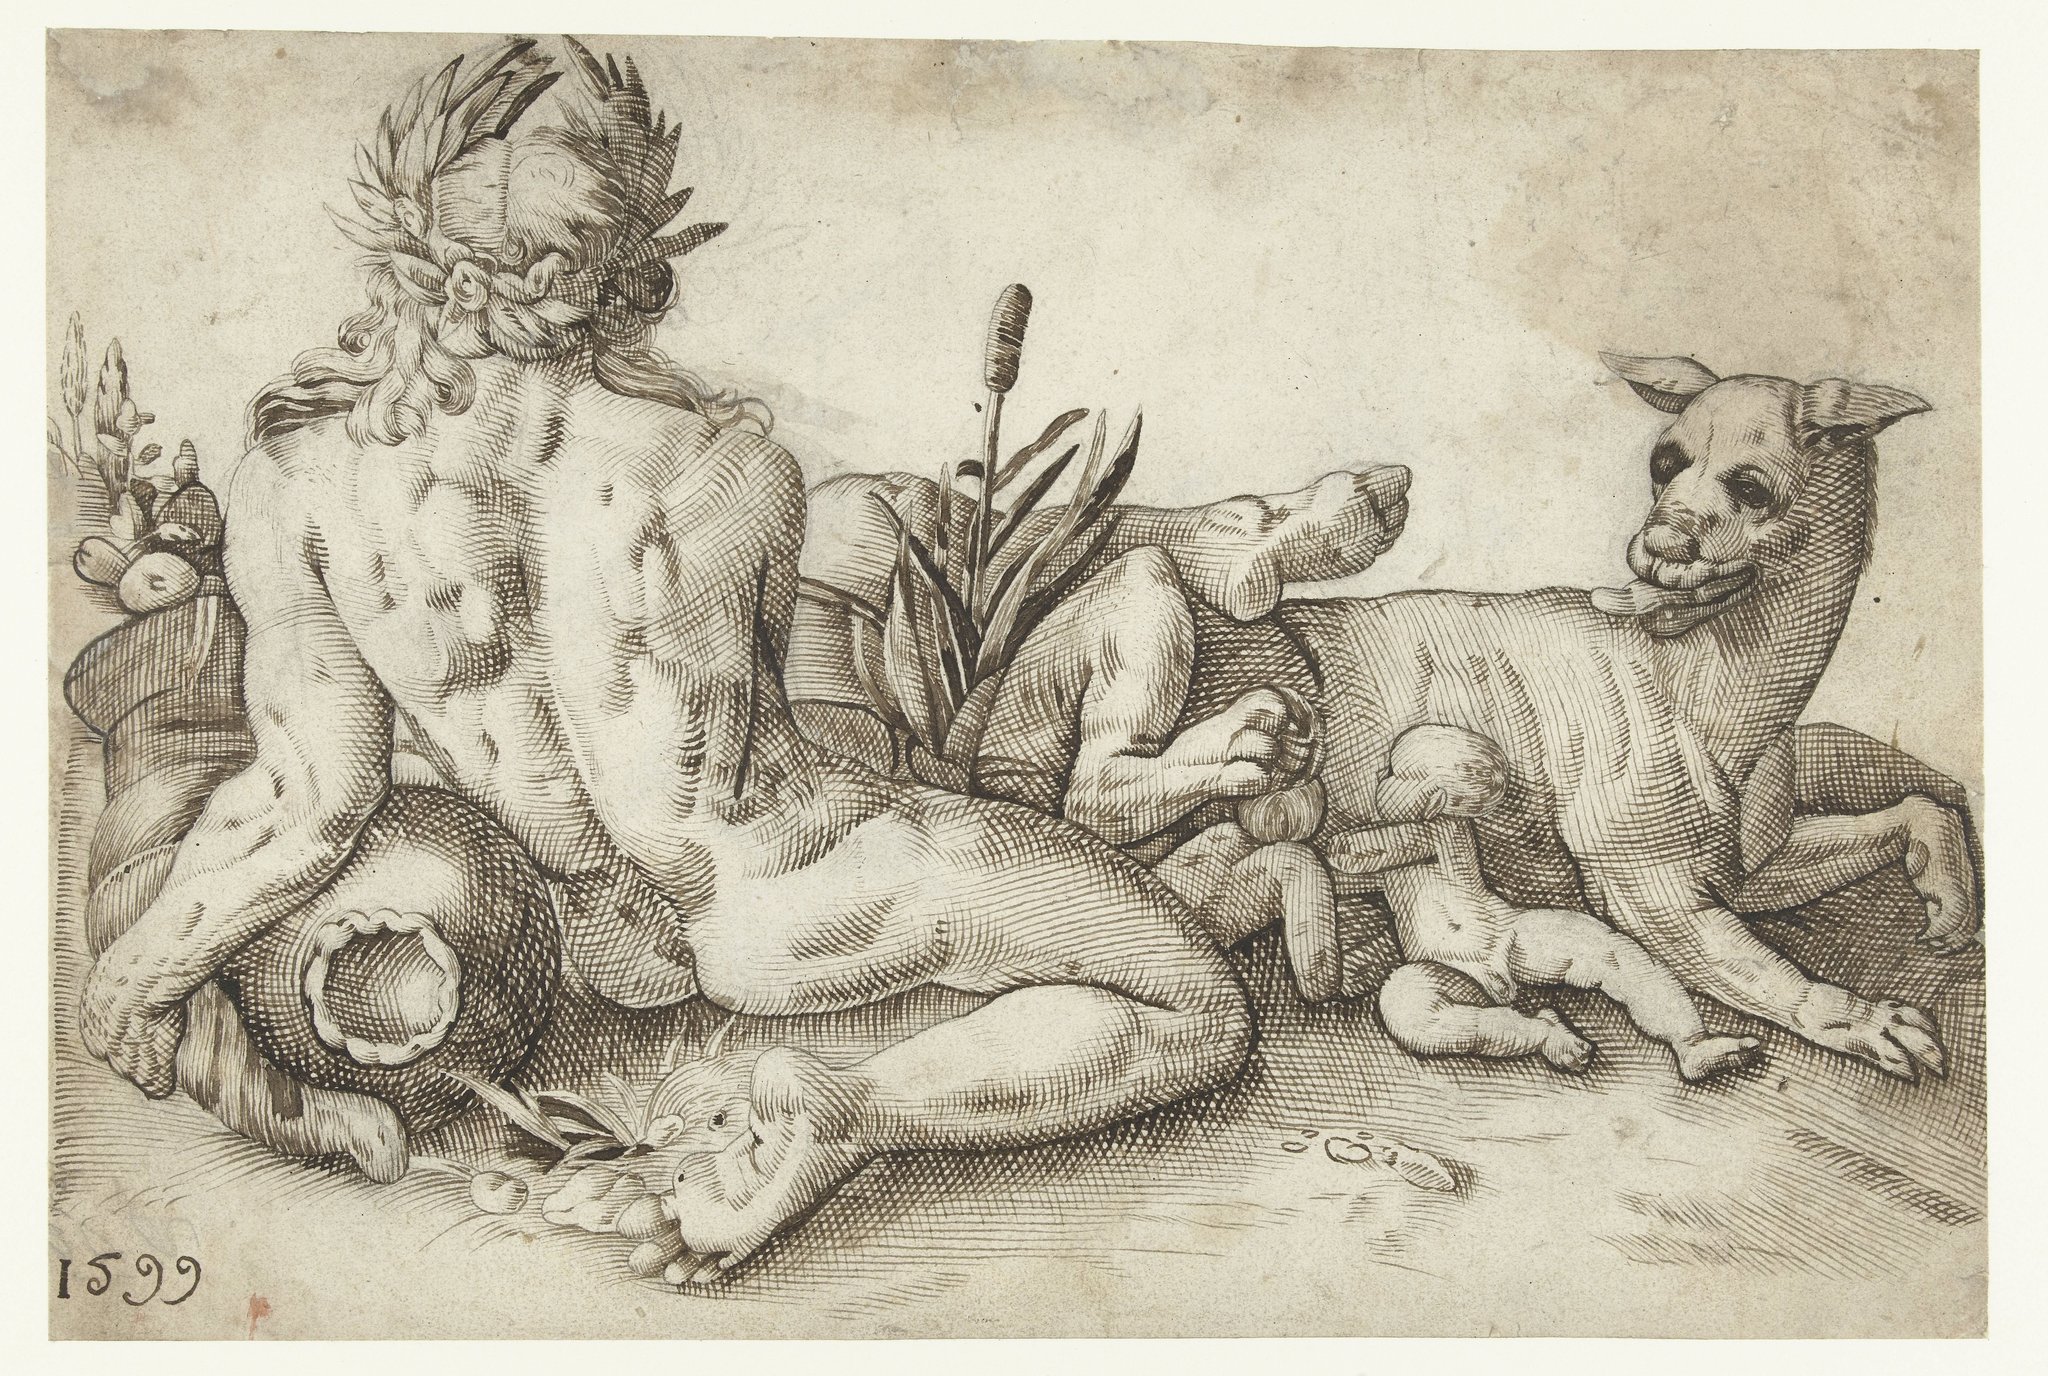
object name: drawing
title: Romeinse helden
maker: lucas van haelwech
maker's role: draughtsman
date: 1599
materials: ink, paper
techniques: pen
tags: beasts of prey, predatory animals: wolf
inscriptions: date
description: Detail van titelblad uit serie van tien bladen met Romeinse Helden.